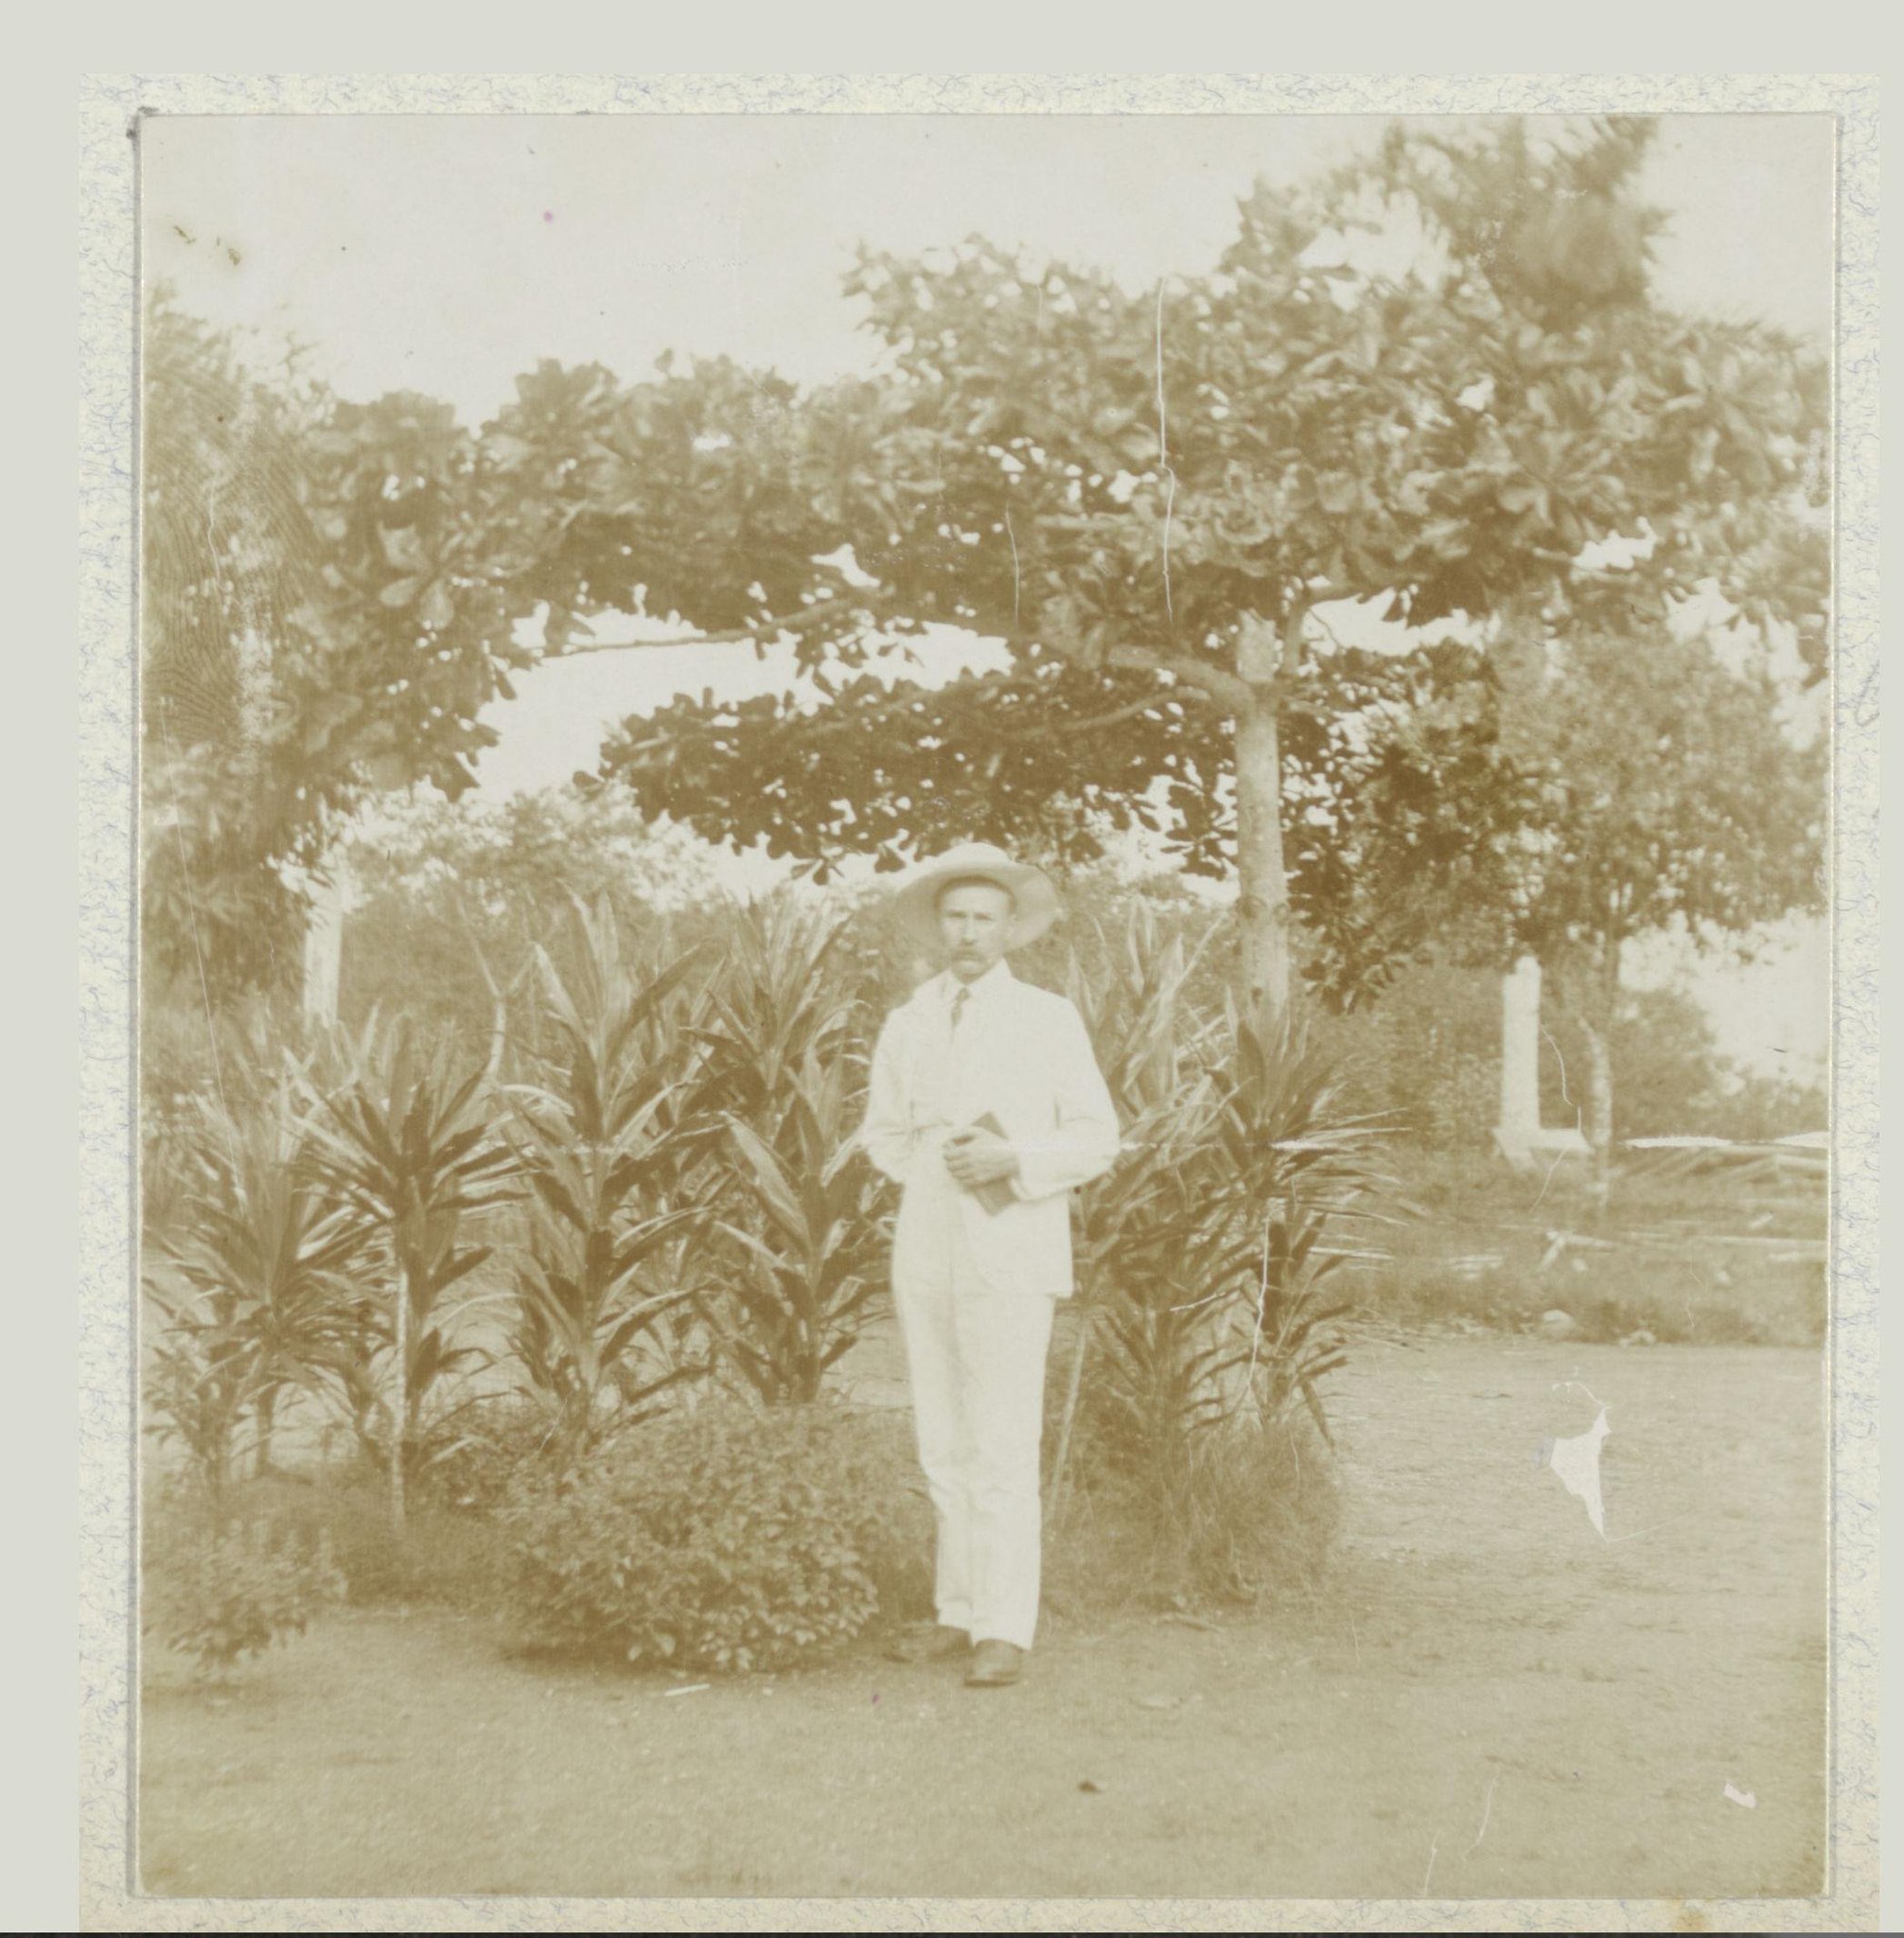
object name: photograph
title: Zendeling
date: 1908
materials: photographic support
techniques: photography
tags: amsterdam, andries augustus boom, spreading the gospel; missionary work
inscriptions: inscription: ‘Oude man de zendeling. P'bo 1908’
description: Andries Boom staande in een tuin, als zendeling. Paramaribo 1908. Onderdeel van het fotoalbum van de familie Boom-Gonggrijp in Suriname en Curaçao.